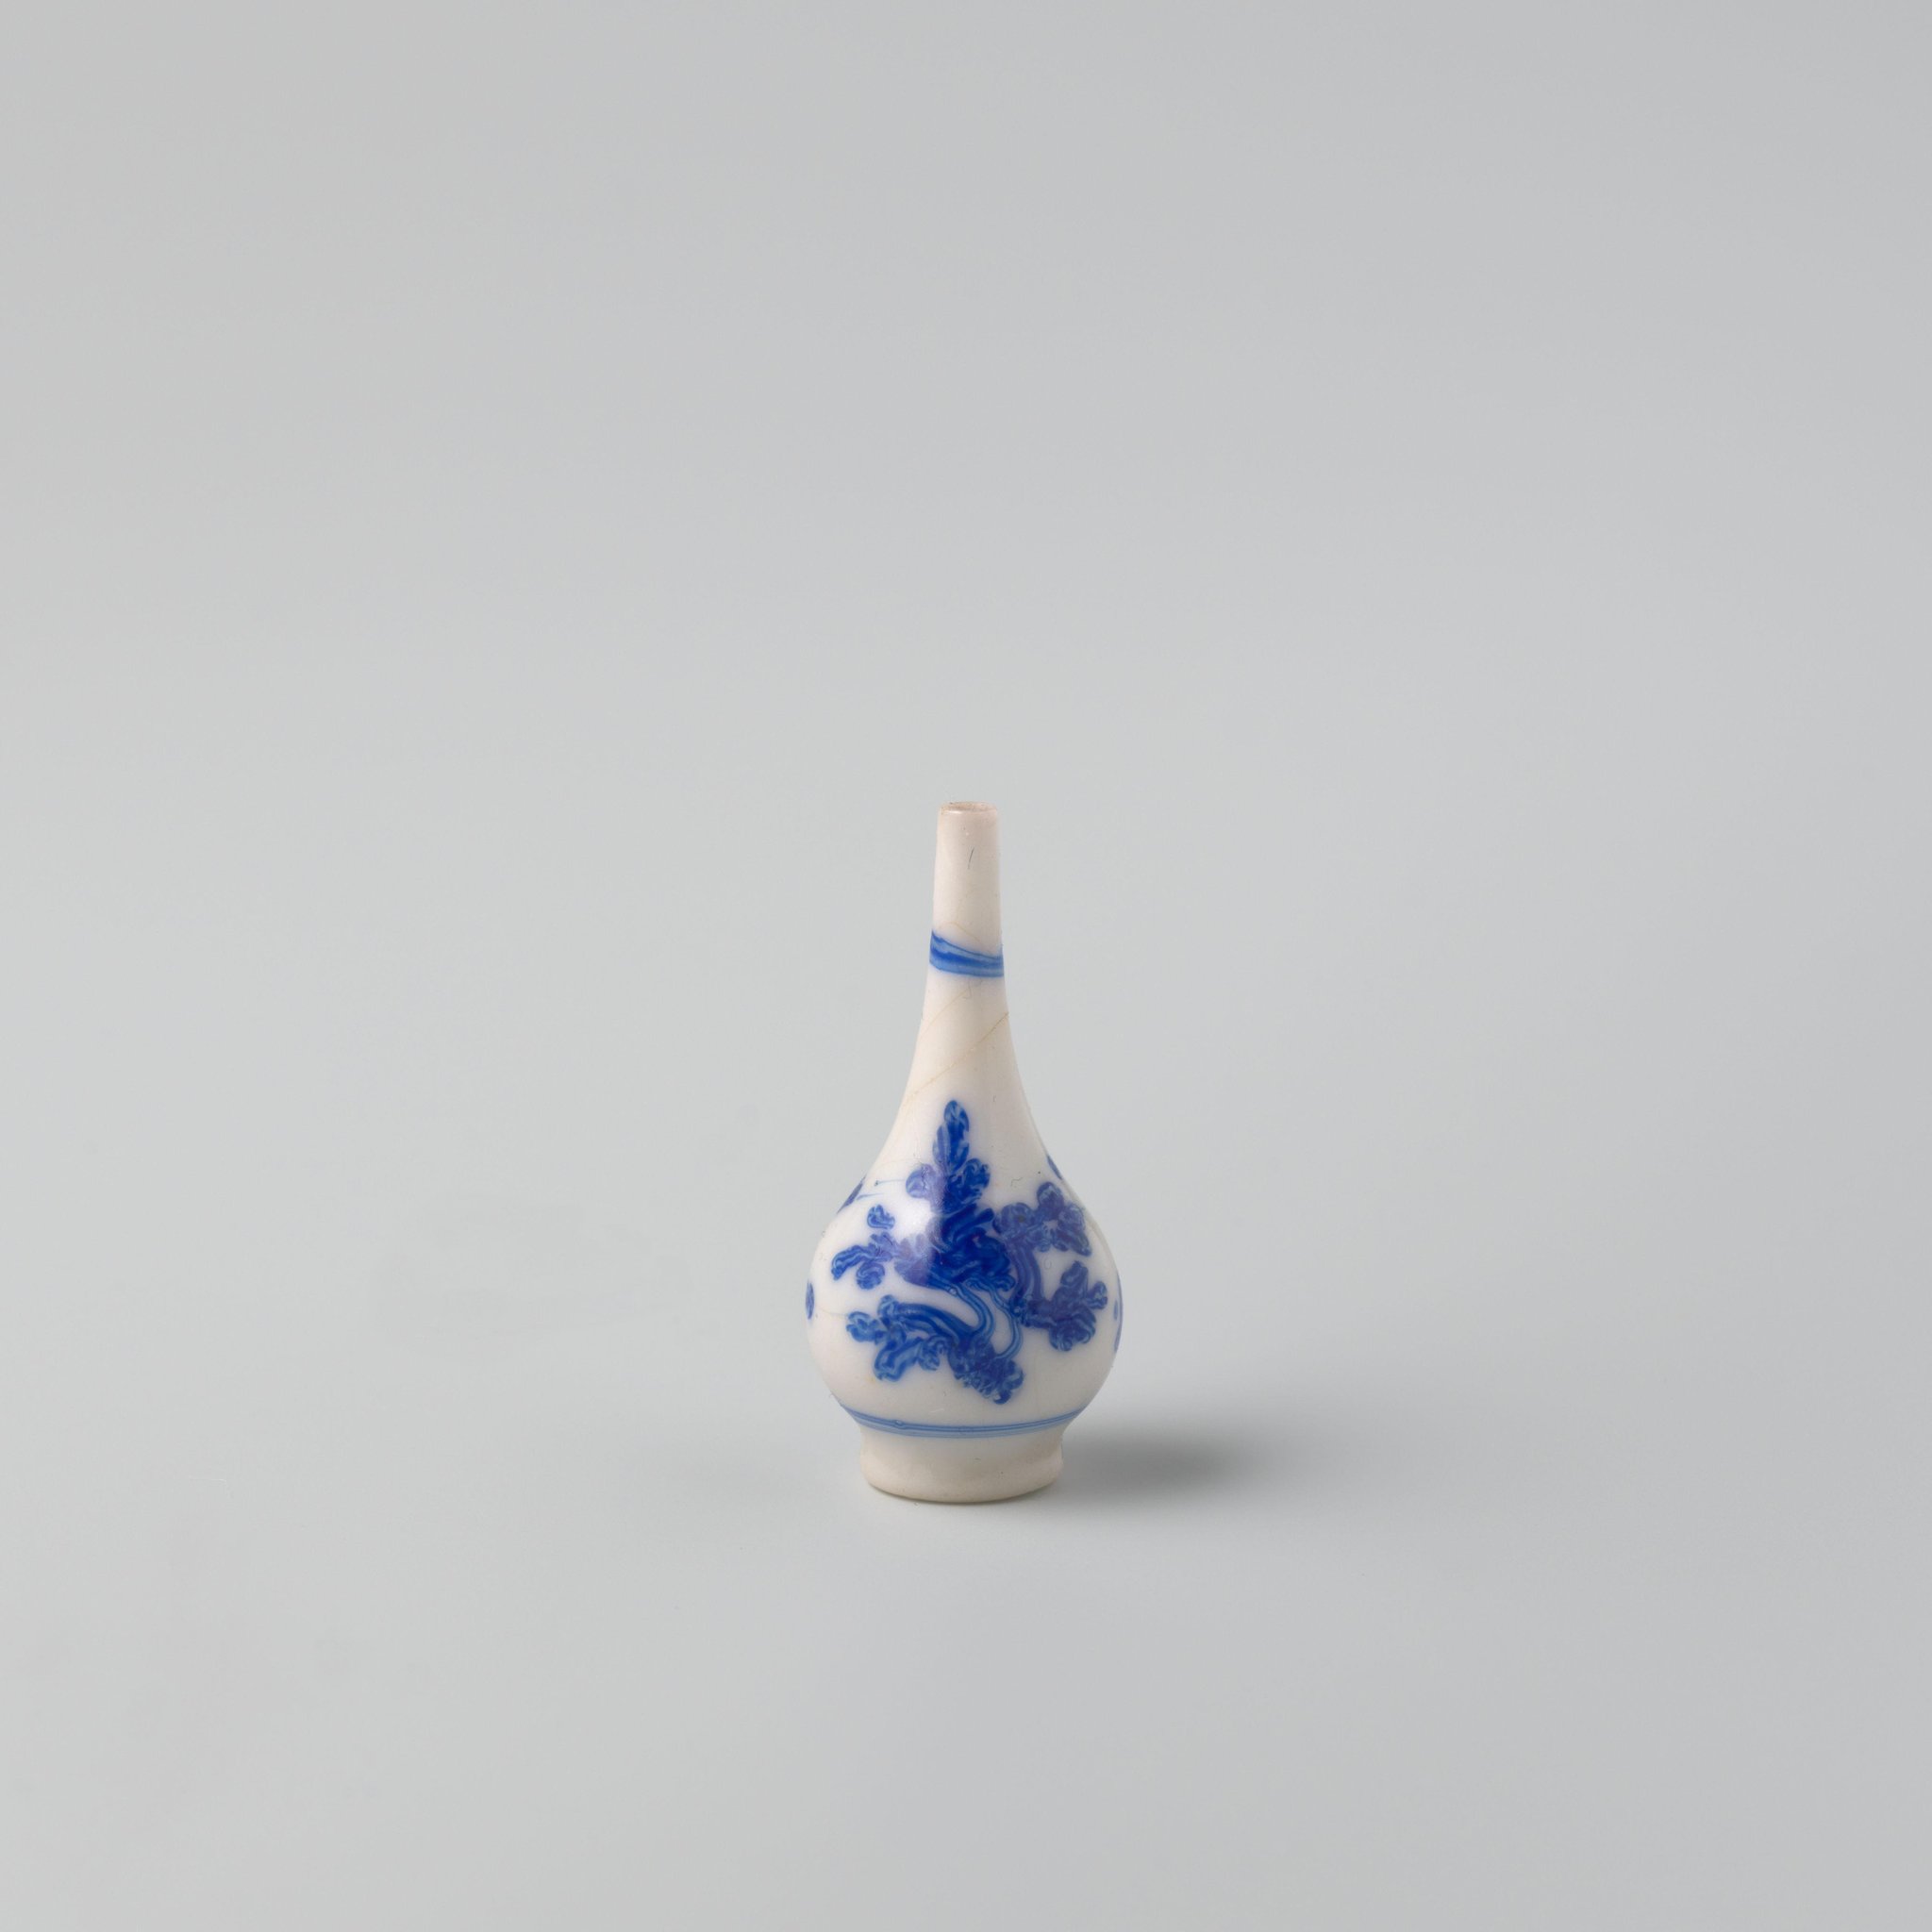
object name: bottle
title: Fles van melkglas met blauwe emailverf beschildering, imitatie Chinees porselein; peervormig op standring, decoratie van bloem tuilen.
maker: Anonymous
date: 1675-1710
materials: glass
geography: amsterdam